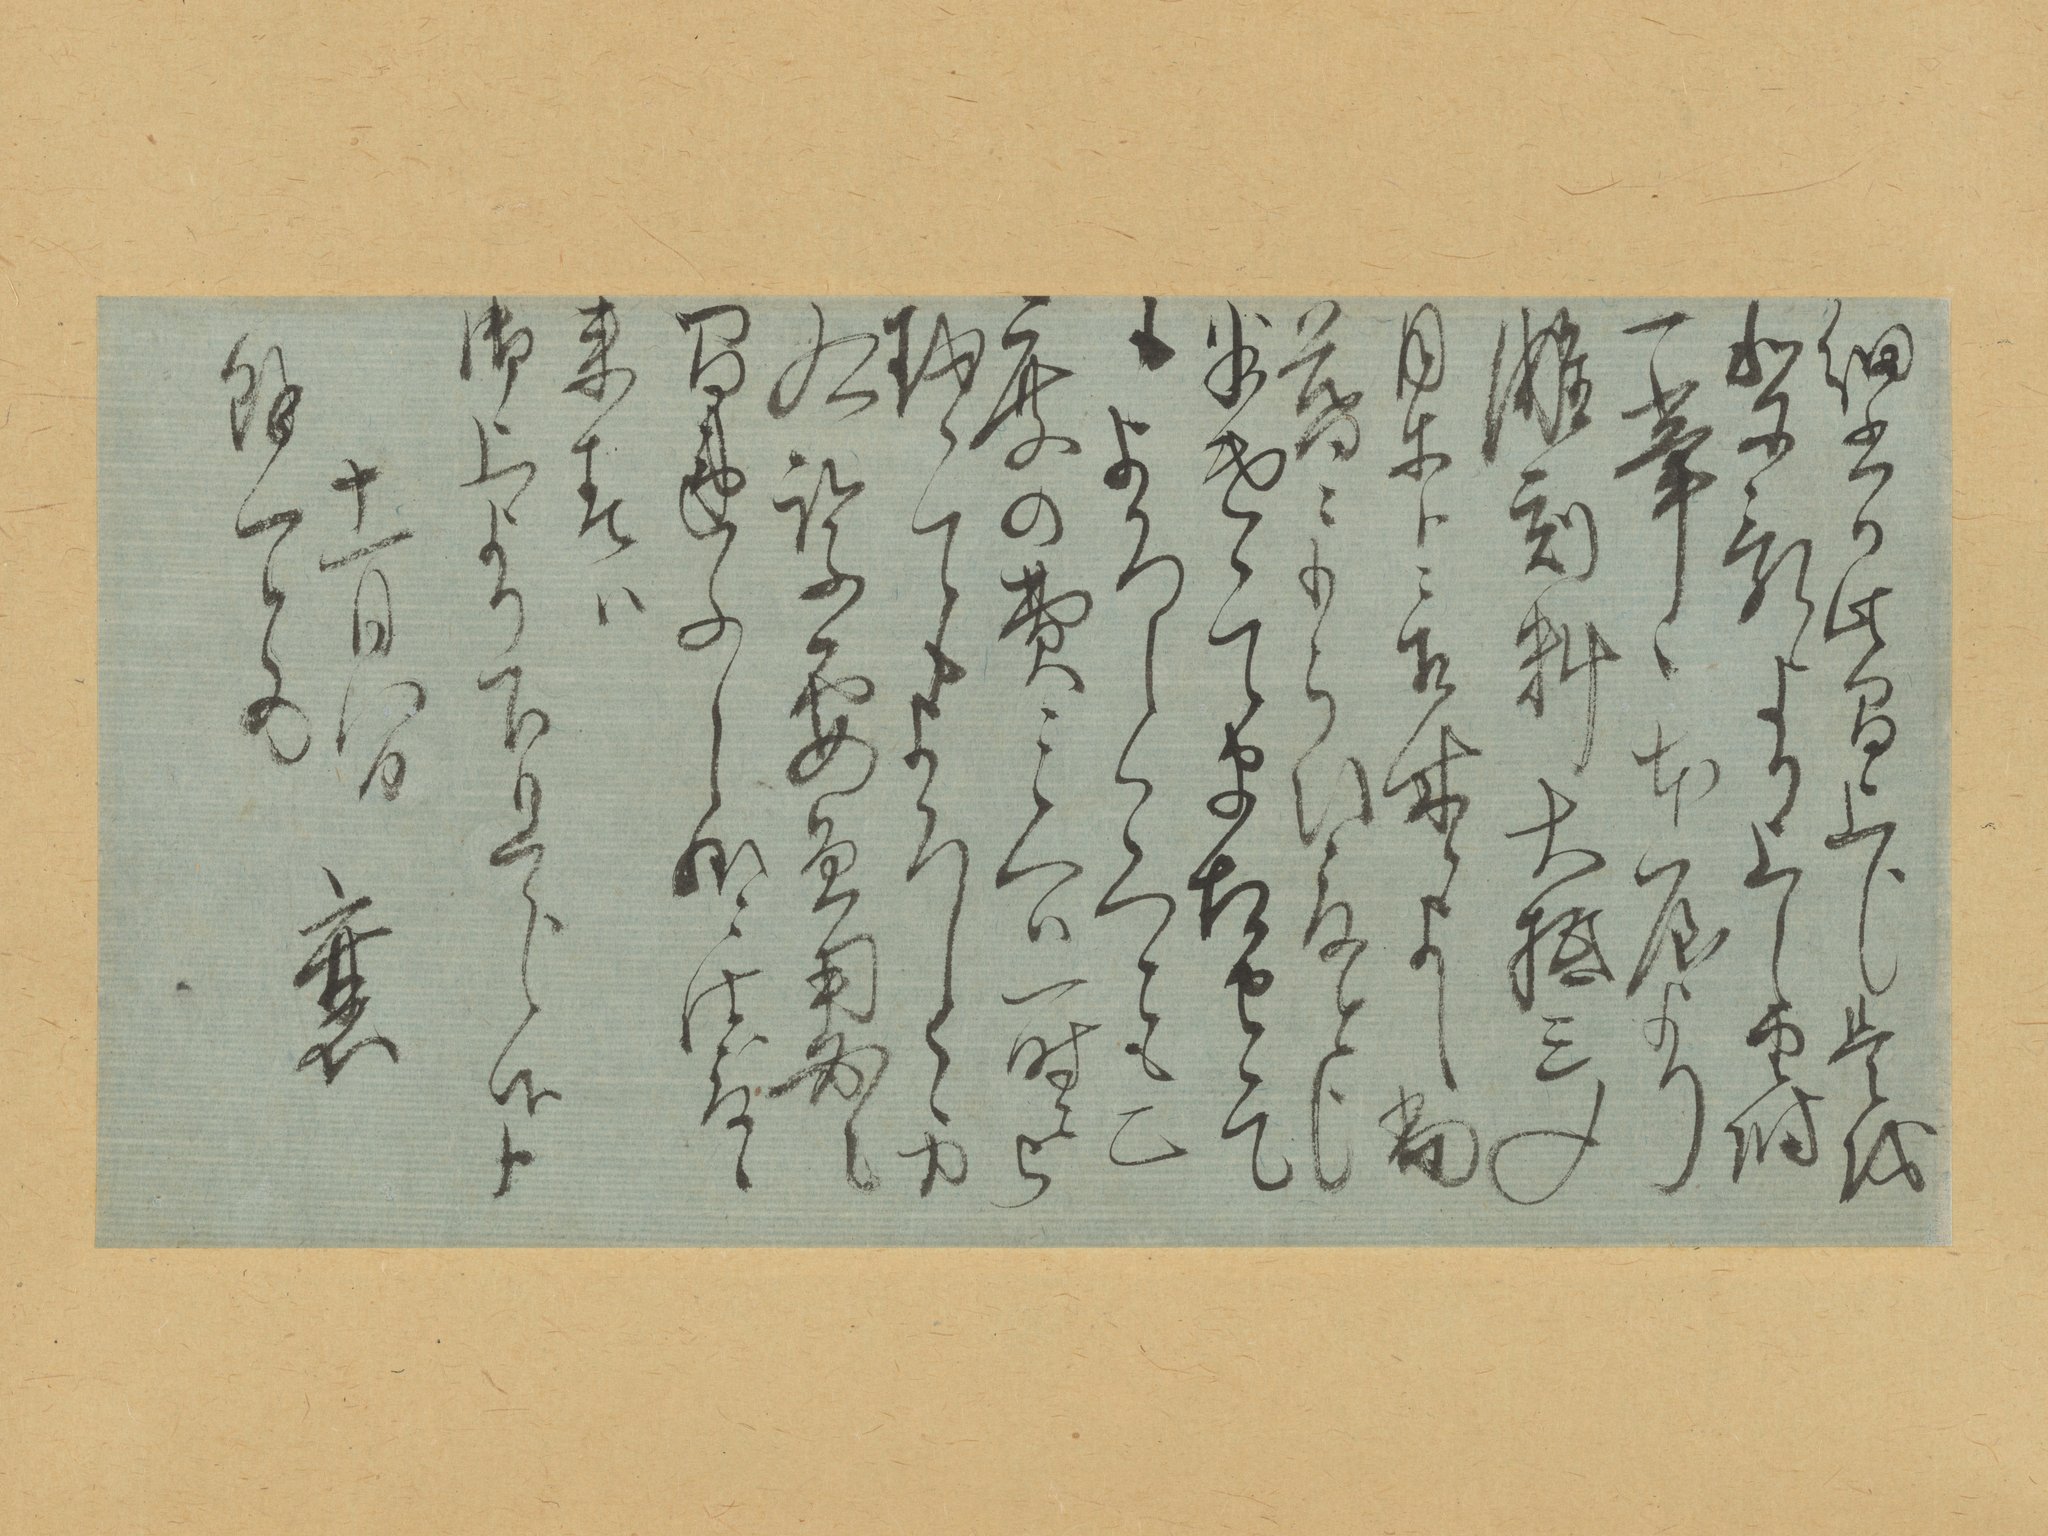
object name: hanging scroll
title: Letter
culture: japanese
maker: rai san’yō 頼山陽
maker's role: artist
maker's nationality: japanese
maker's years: 1780-1832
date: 1820-1828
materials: ink, paper